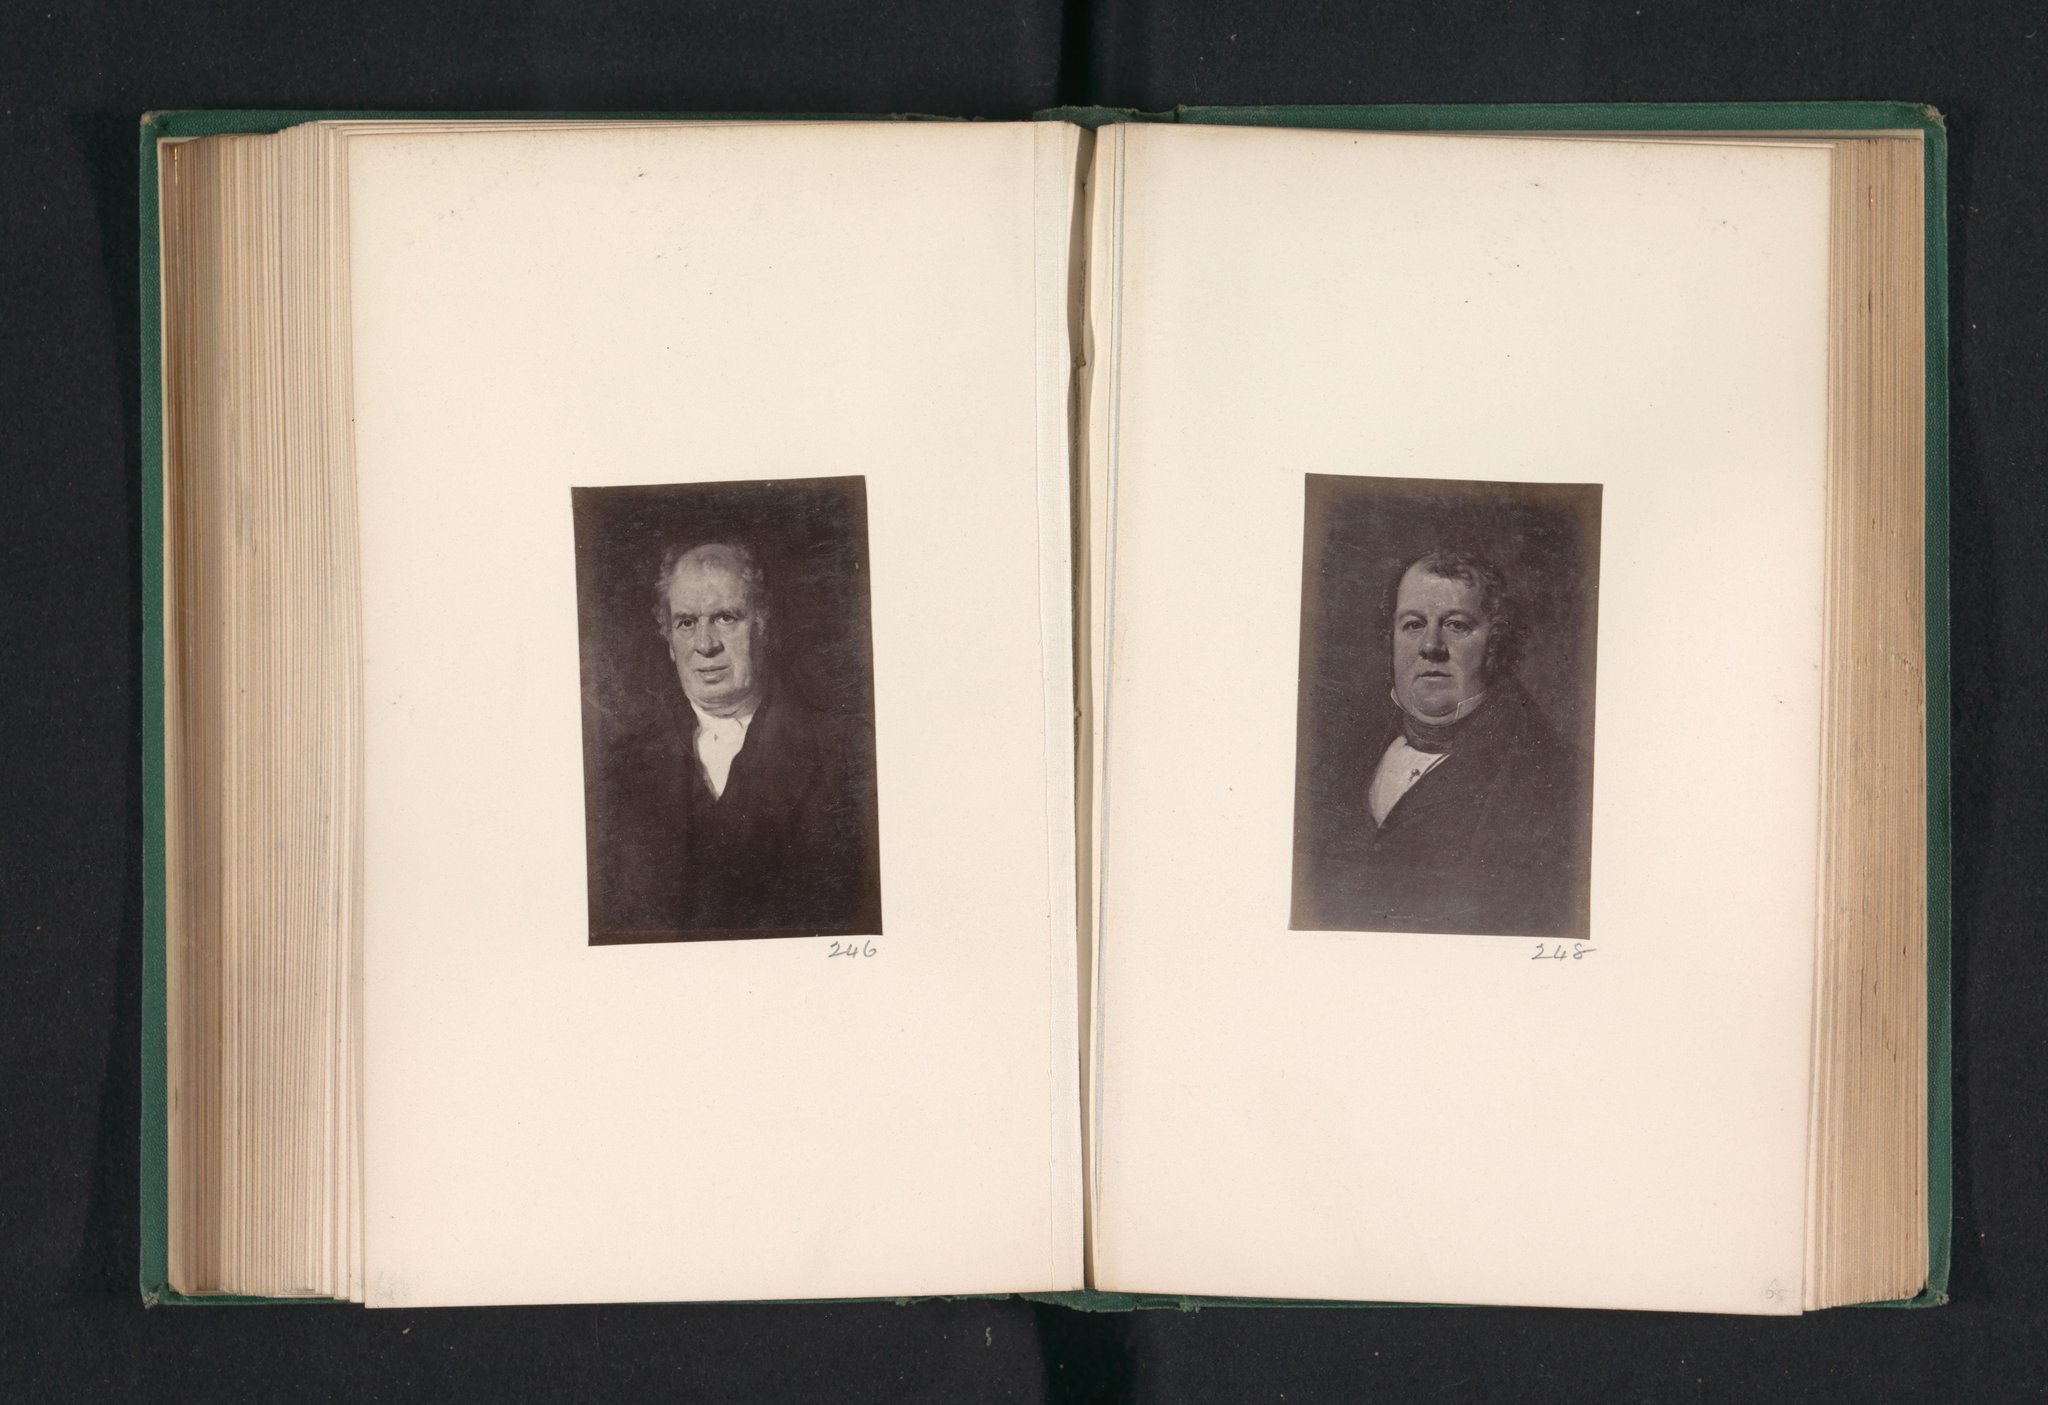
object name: photograph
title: Fotoreproductie van een schilderij, voorstellende een portret van Robert Dalglish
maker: thomas annan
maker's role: fotograaf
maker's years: 1829-1887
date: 1863-1868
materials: photographic support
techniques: albumen print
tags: historical persons (portraits and scenes from the life) (+ (full) bust portrait)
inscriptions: number: ‘246’